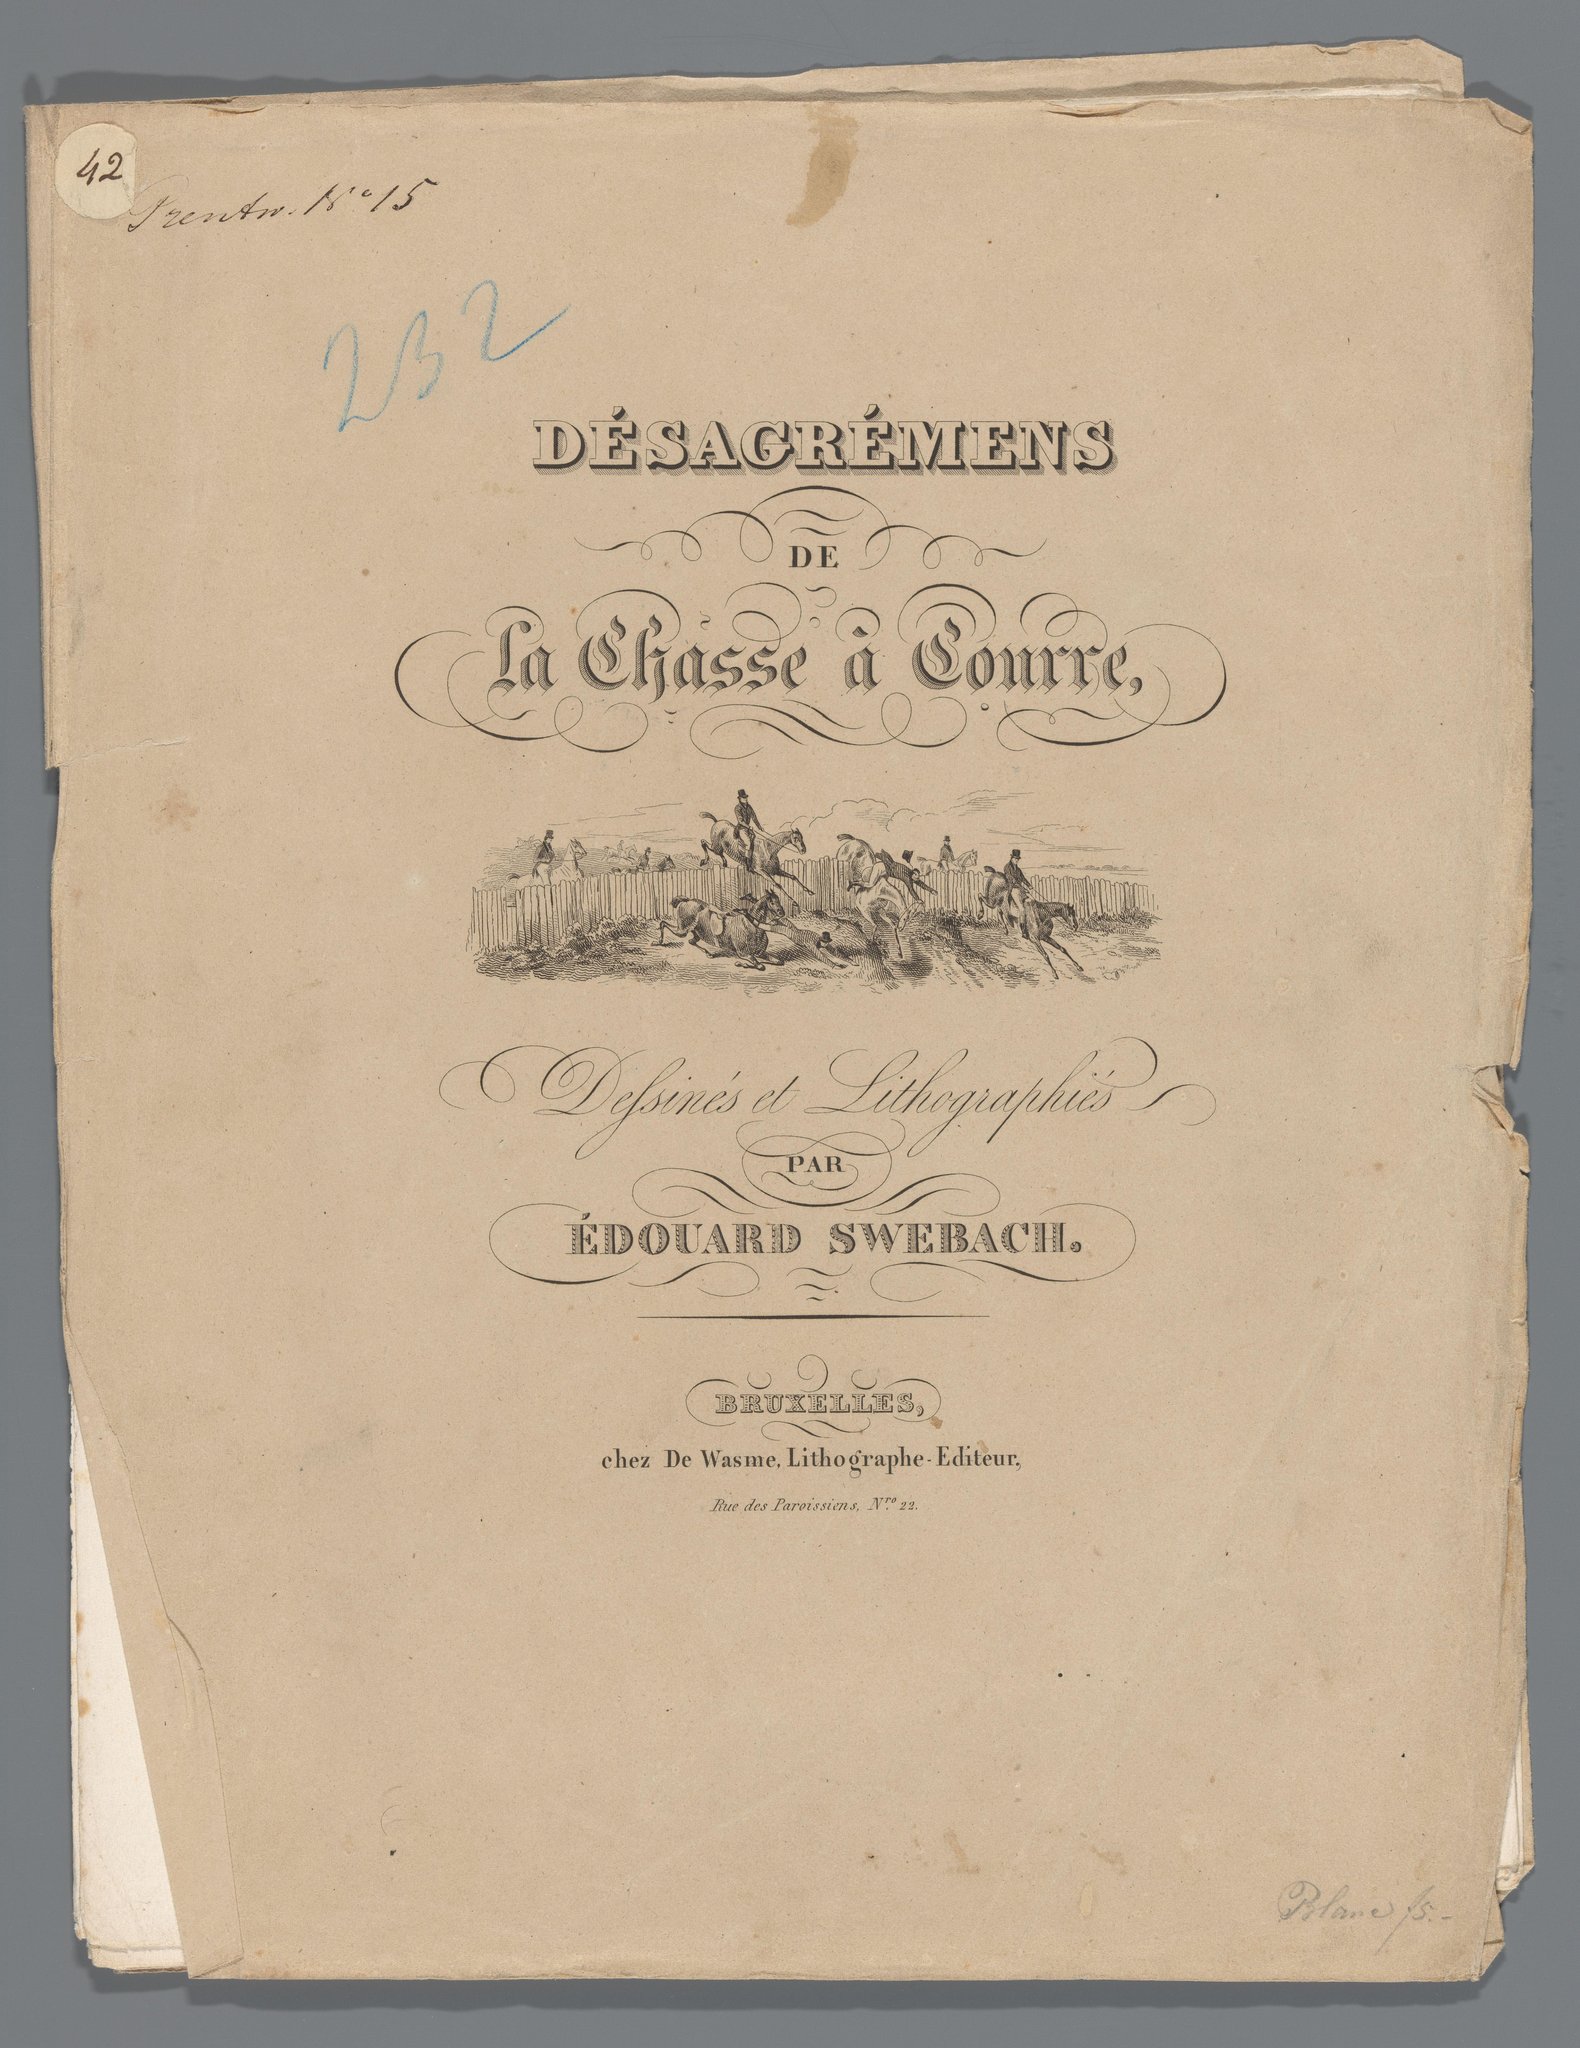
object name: print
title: Ongemakken van de drijfjacht met paarden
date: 1825-1827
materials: paper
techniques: letterpress printing, lithograph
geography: brussels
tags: hunting, chase